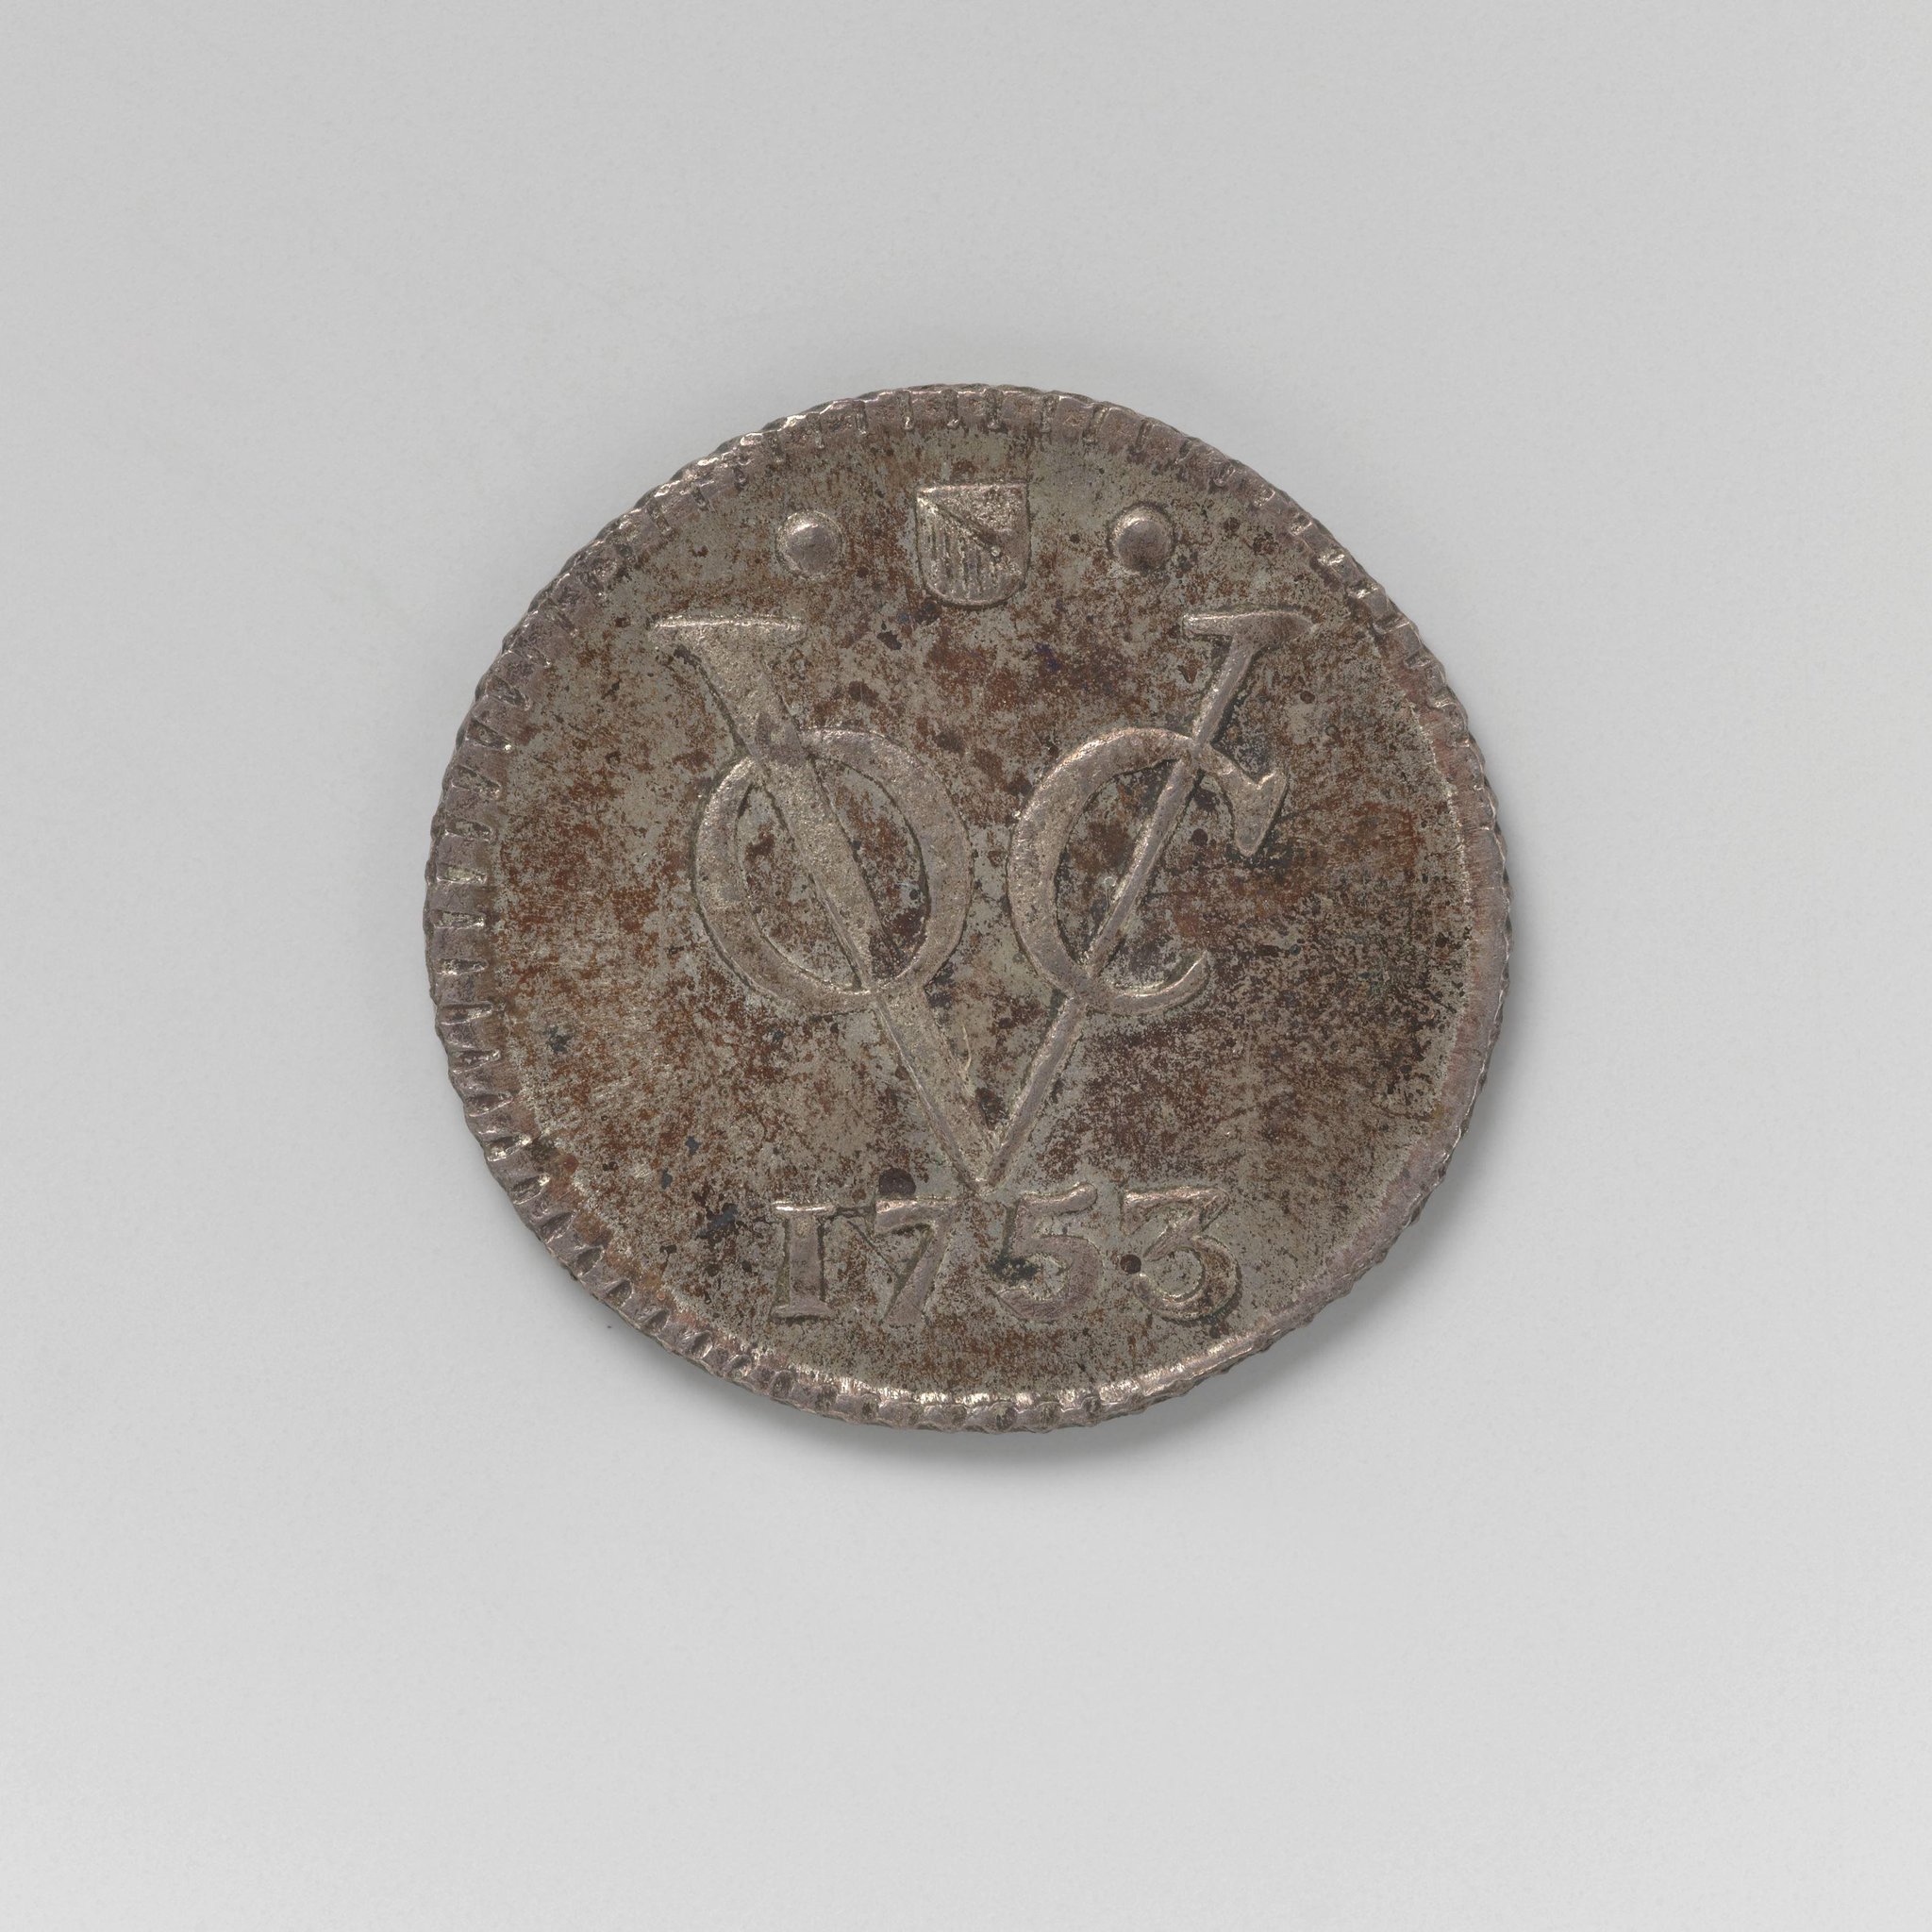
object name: coin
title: VOC, ½ duit, stad Utrecht,1753. Afslag in zilver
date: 1753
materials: silver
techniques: striking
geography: utrecht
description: Zilveren munt. Voorzijde: op balk, waaronder guirlande, staand, door twee leeuwen gehouden gekroond wapenschild van de stad Utrecht. Keerzijde: monogram van de VOC, waarboven muntteken en waaronder jaartal. Kartelrand.